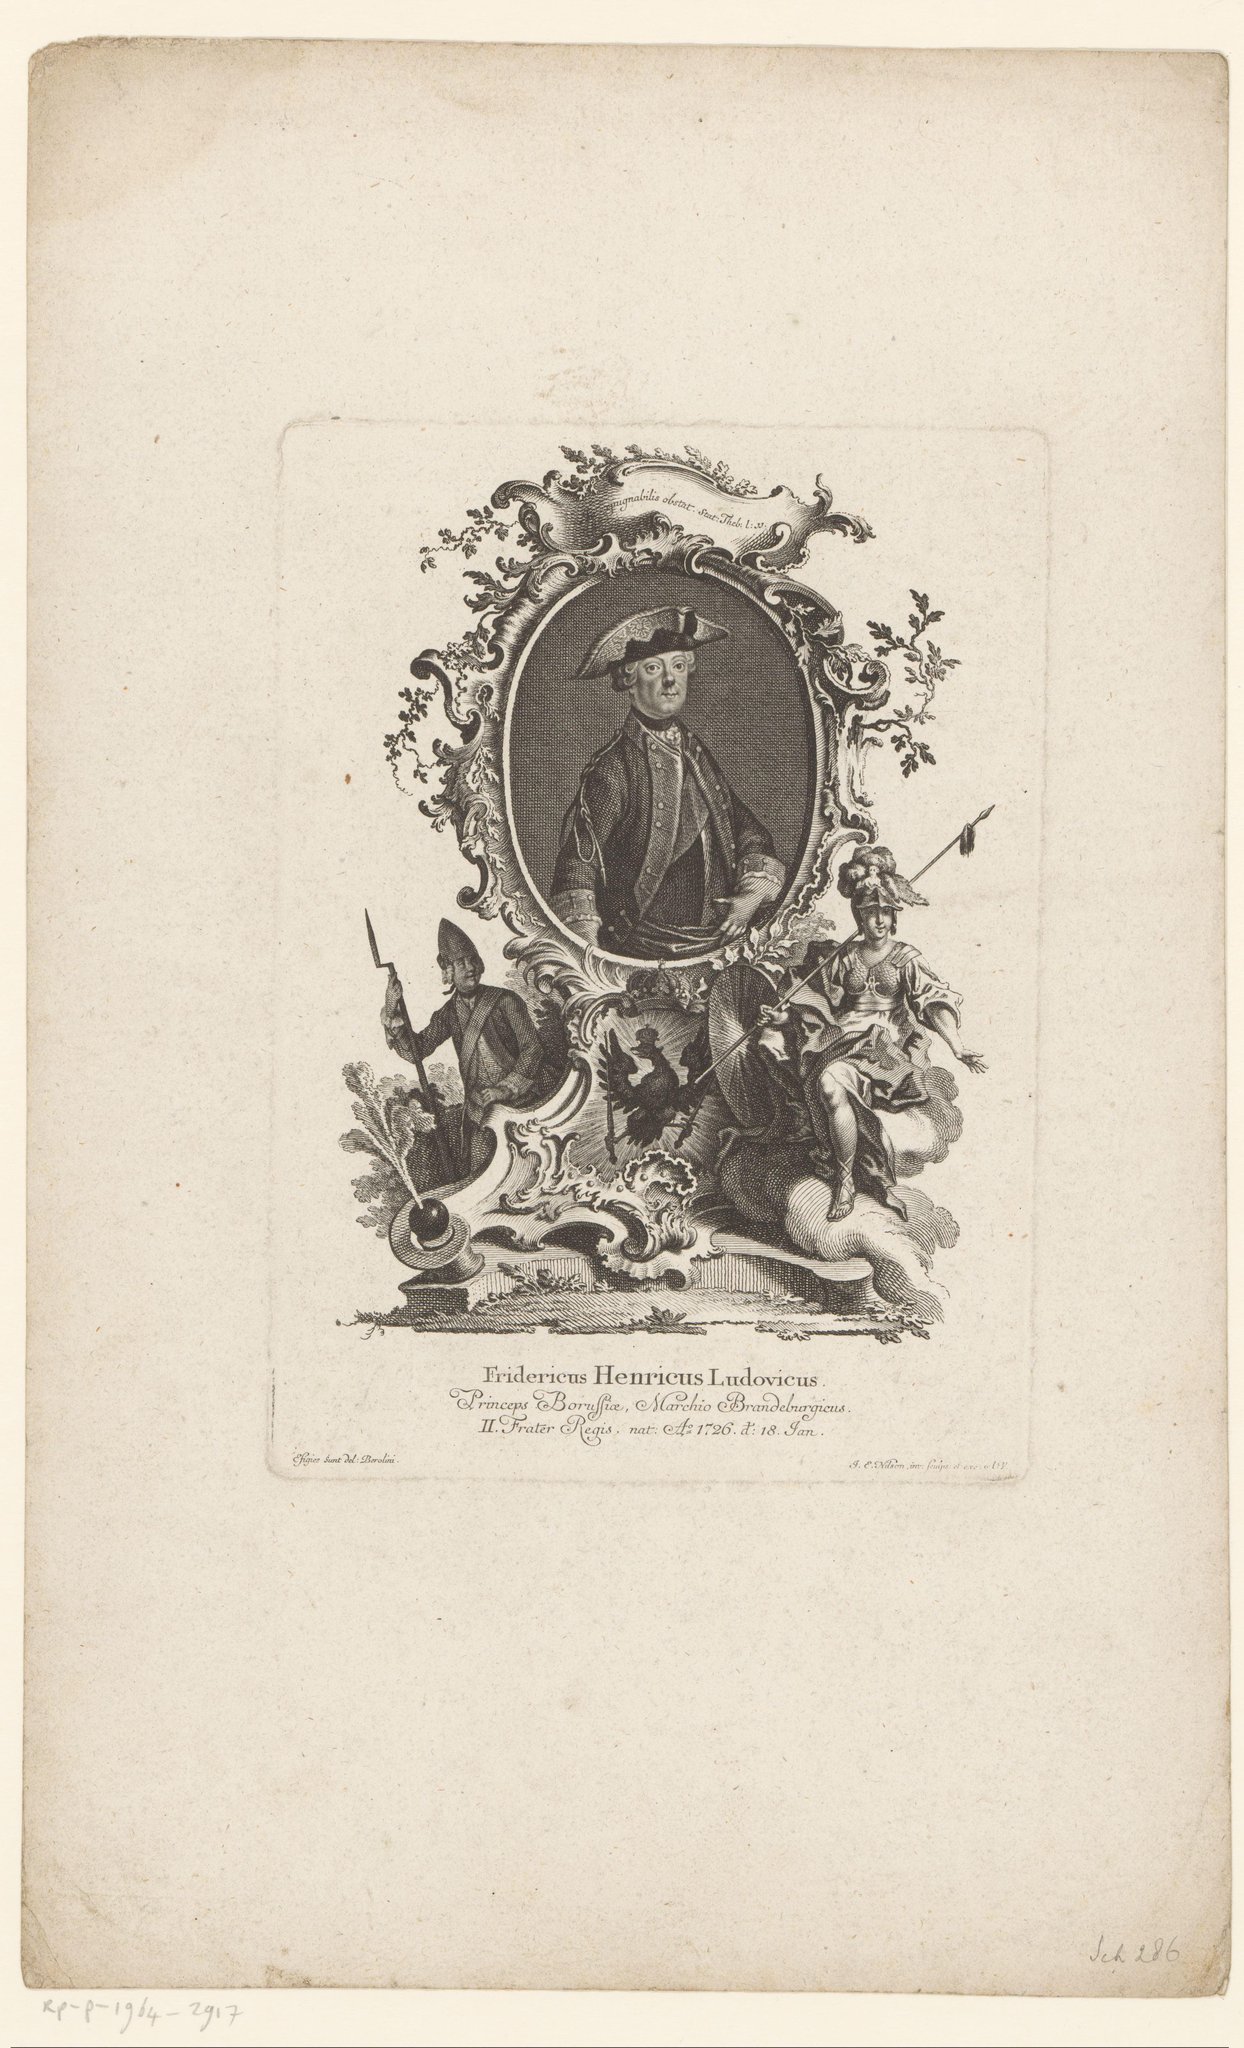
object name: print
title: Portret van Friedrich Heinrich Ludwig van Pruisen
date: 1746-1788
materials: paper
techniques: engraving, etching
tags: berlin, friedrich heinrich ludwig van pruisen, historical persons, the soldier; the soldier's life, attributes of minerva, armorial bearing, heraldry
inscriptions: collector's mark: Lugt 2228